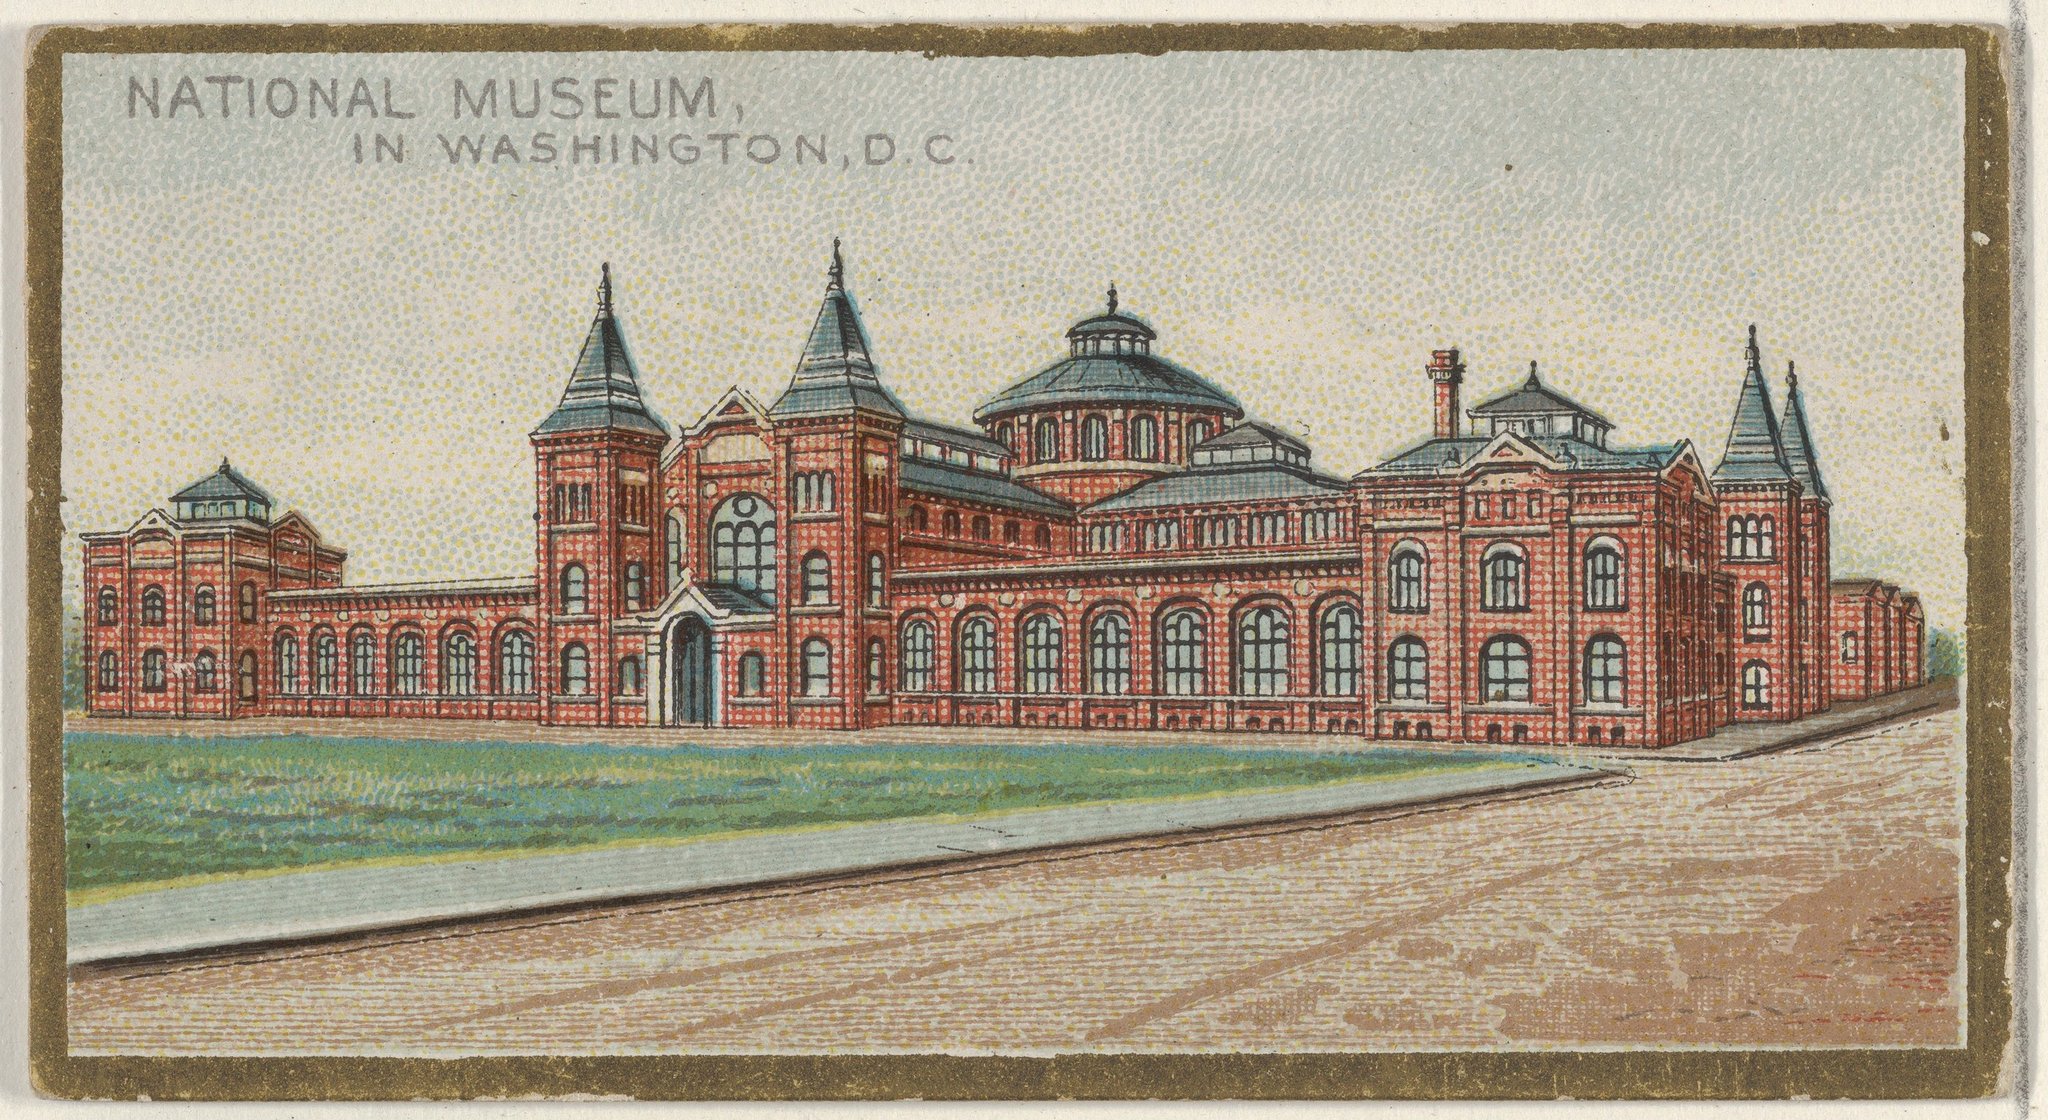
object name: print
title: National Museum in Washington, from the General Government and State Capitol Buildings series (N14) for Allen & Ginter Cigarettes Brands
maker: allen & ginter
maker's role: publisher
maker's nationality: american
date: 1889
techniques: color lithograph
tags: museums